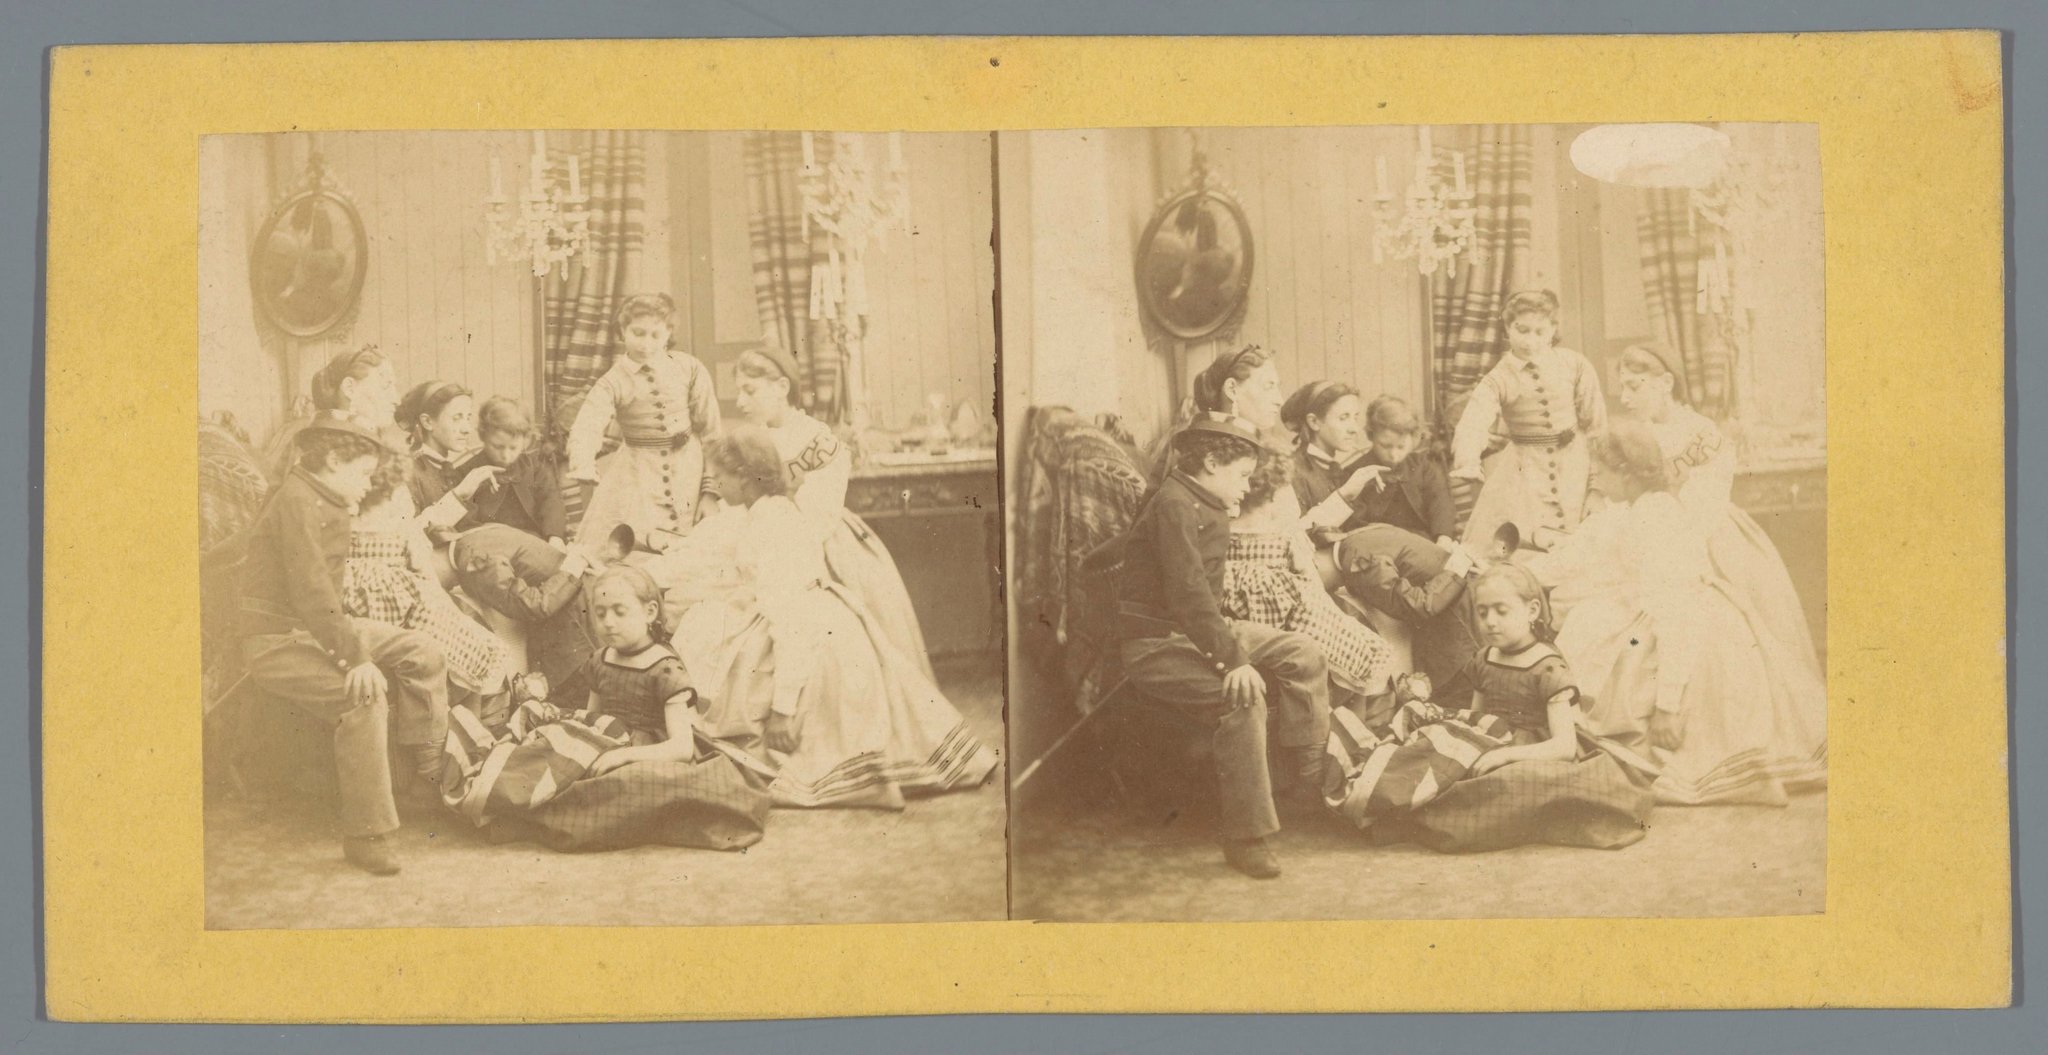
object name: stereograph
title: Twee vrouwen met kinderen in een kamer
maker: Anonymous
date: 1850-1870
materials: cardboard, photographic support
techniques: albumen print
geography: europe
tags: taking care of children, europe